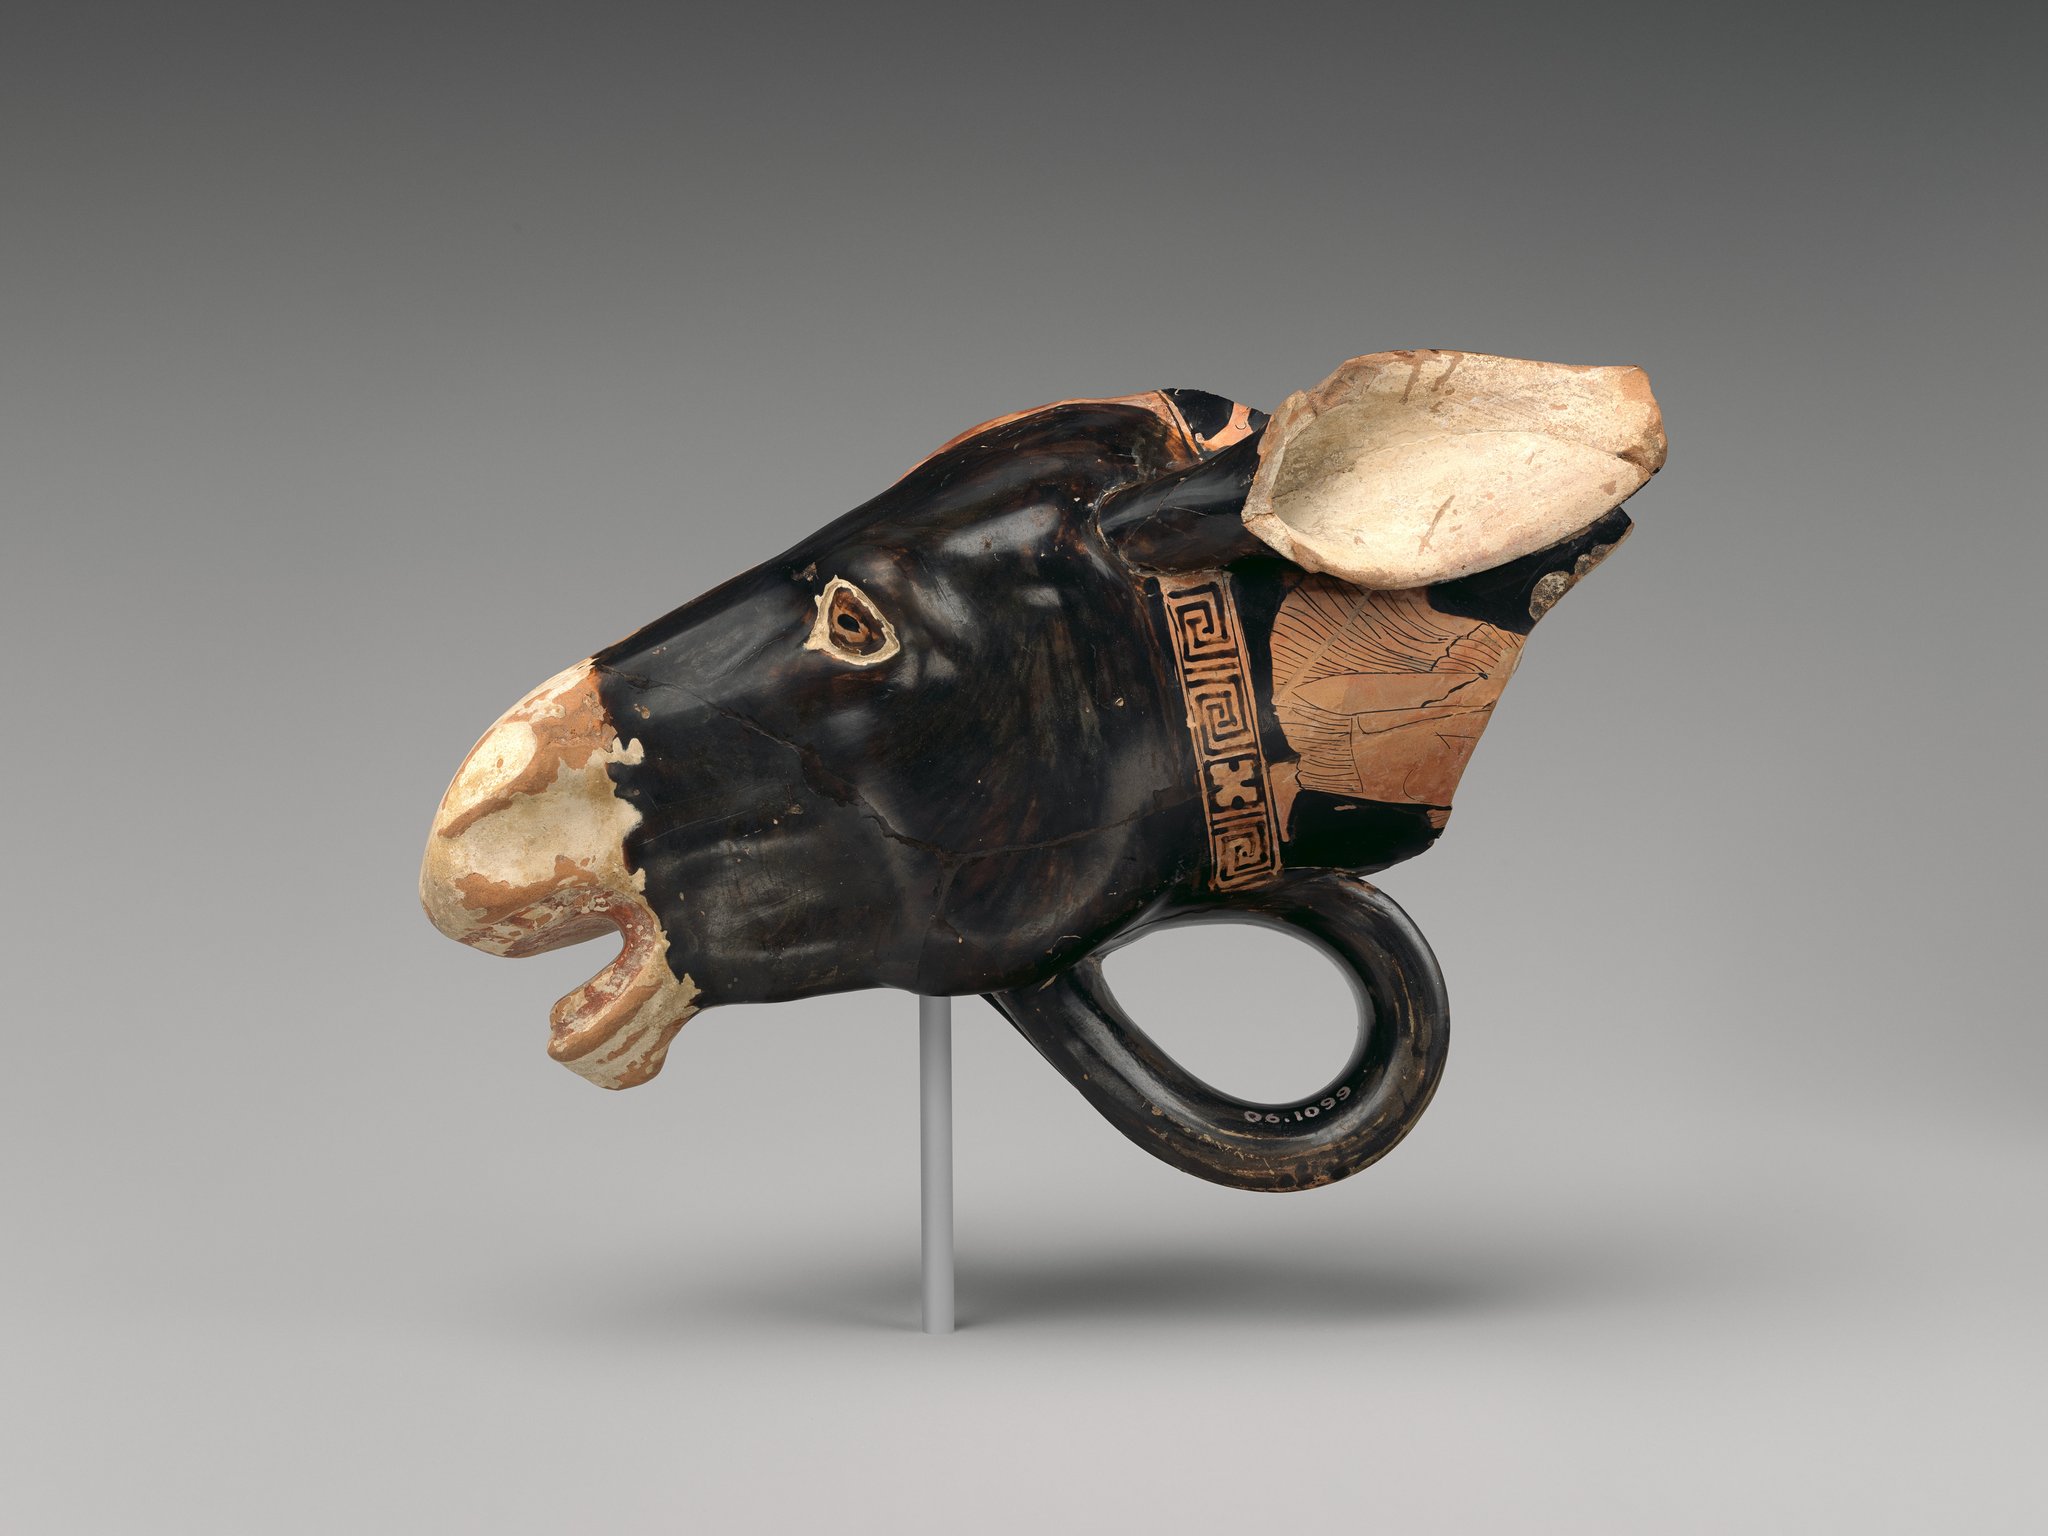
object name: rhyton in the form of a mule and ram head, fragmentary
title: Fragmentary terracotta rhyton (vase for libations or drinking)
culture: greek, attic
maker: sotades painter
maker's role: artist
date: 460-450 BCE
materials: terracotta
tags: donkeys,rams